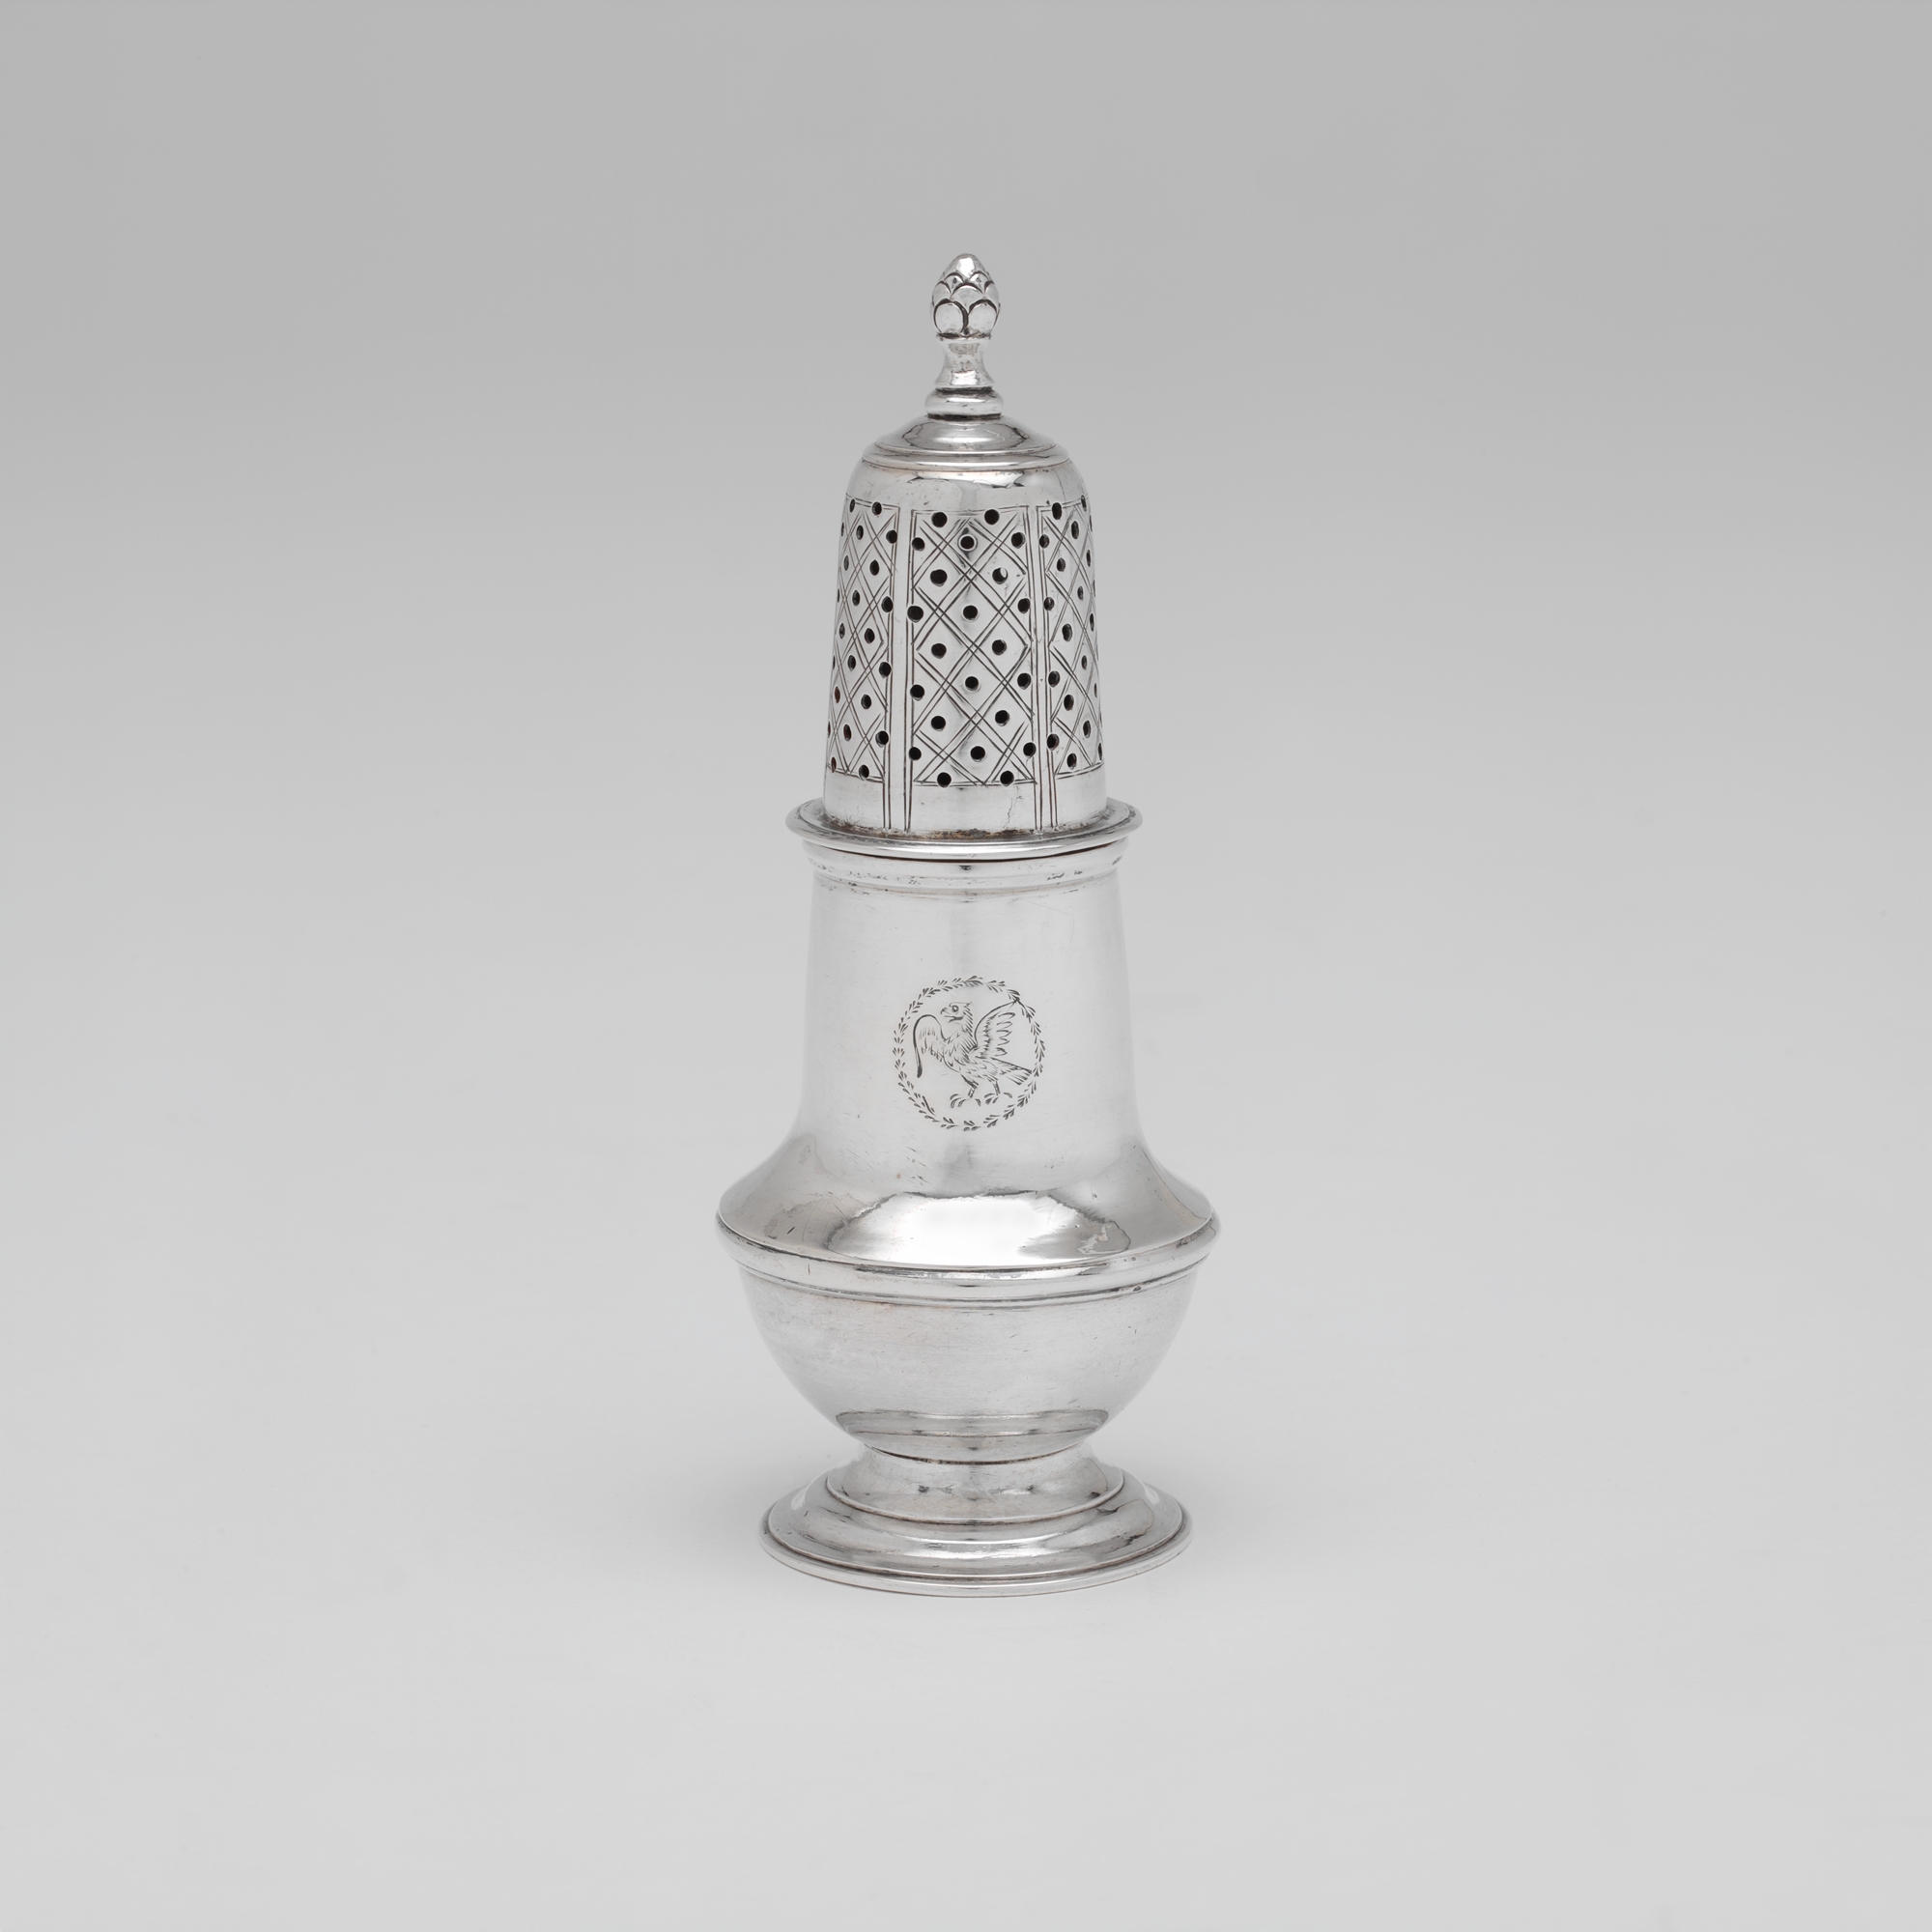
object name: caster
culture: american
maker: mark nelson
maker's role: maker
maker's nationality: american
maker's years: 1733-1787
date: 1750-1770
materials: silver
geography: united states